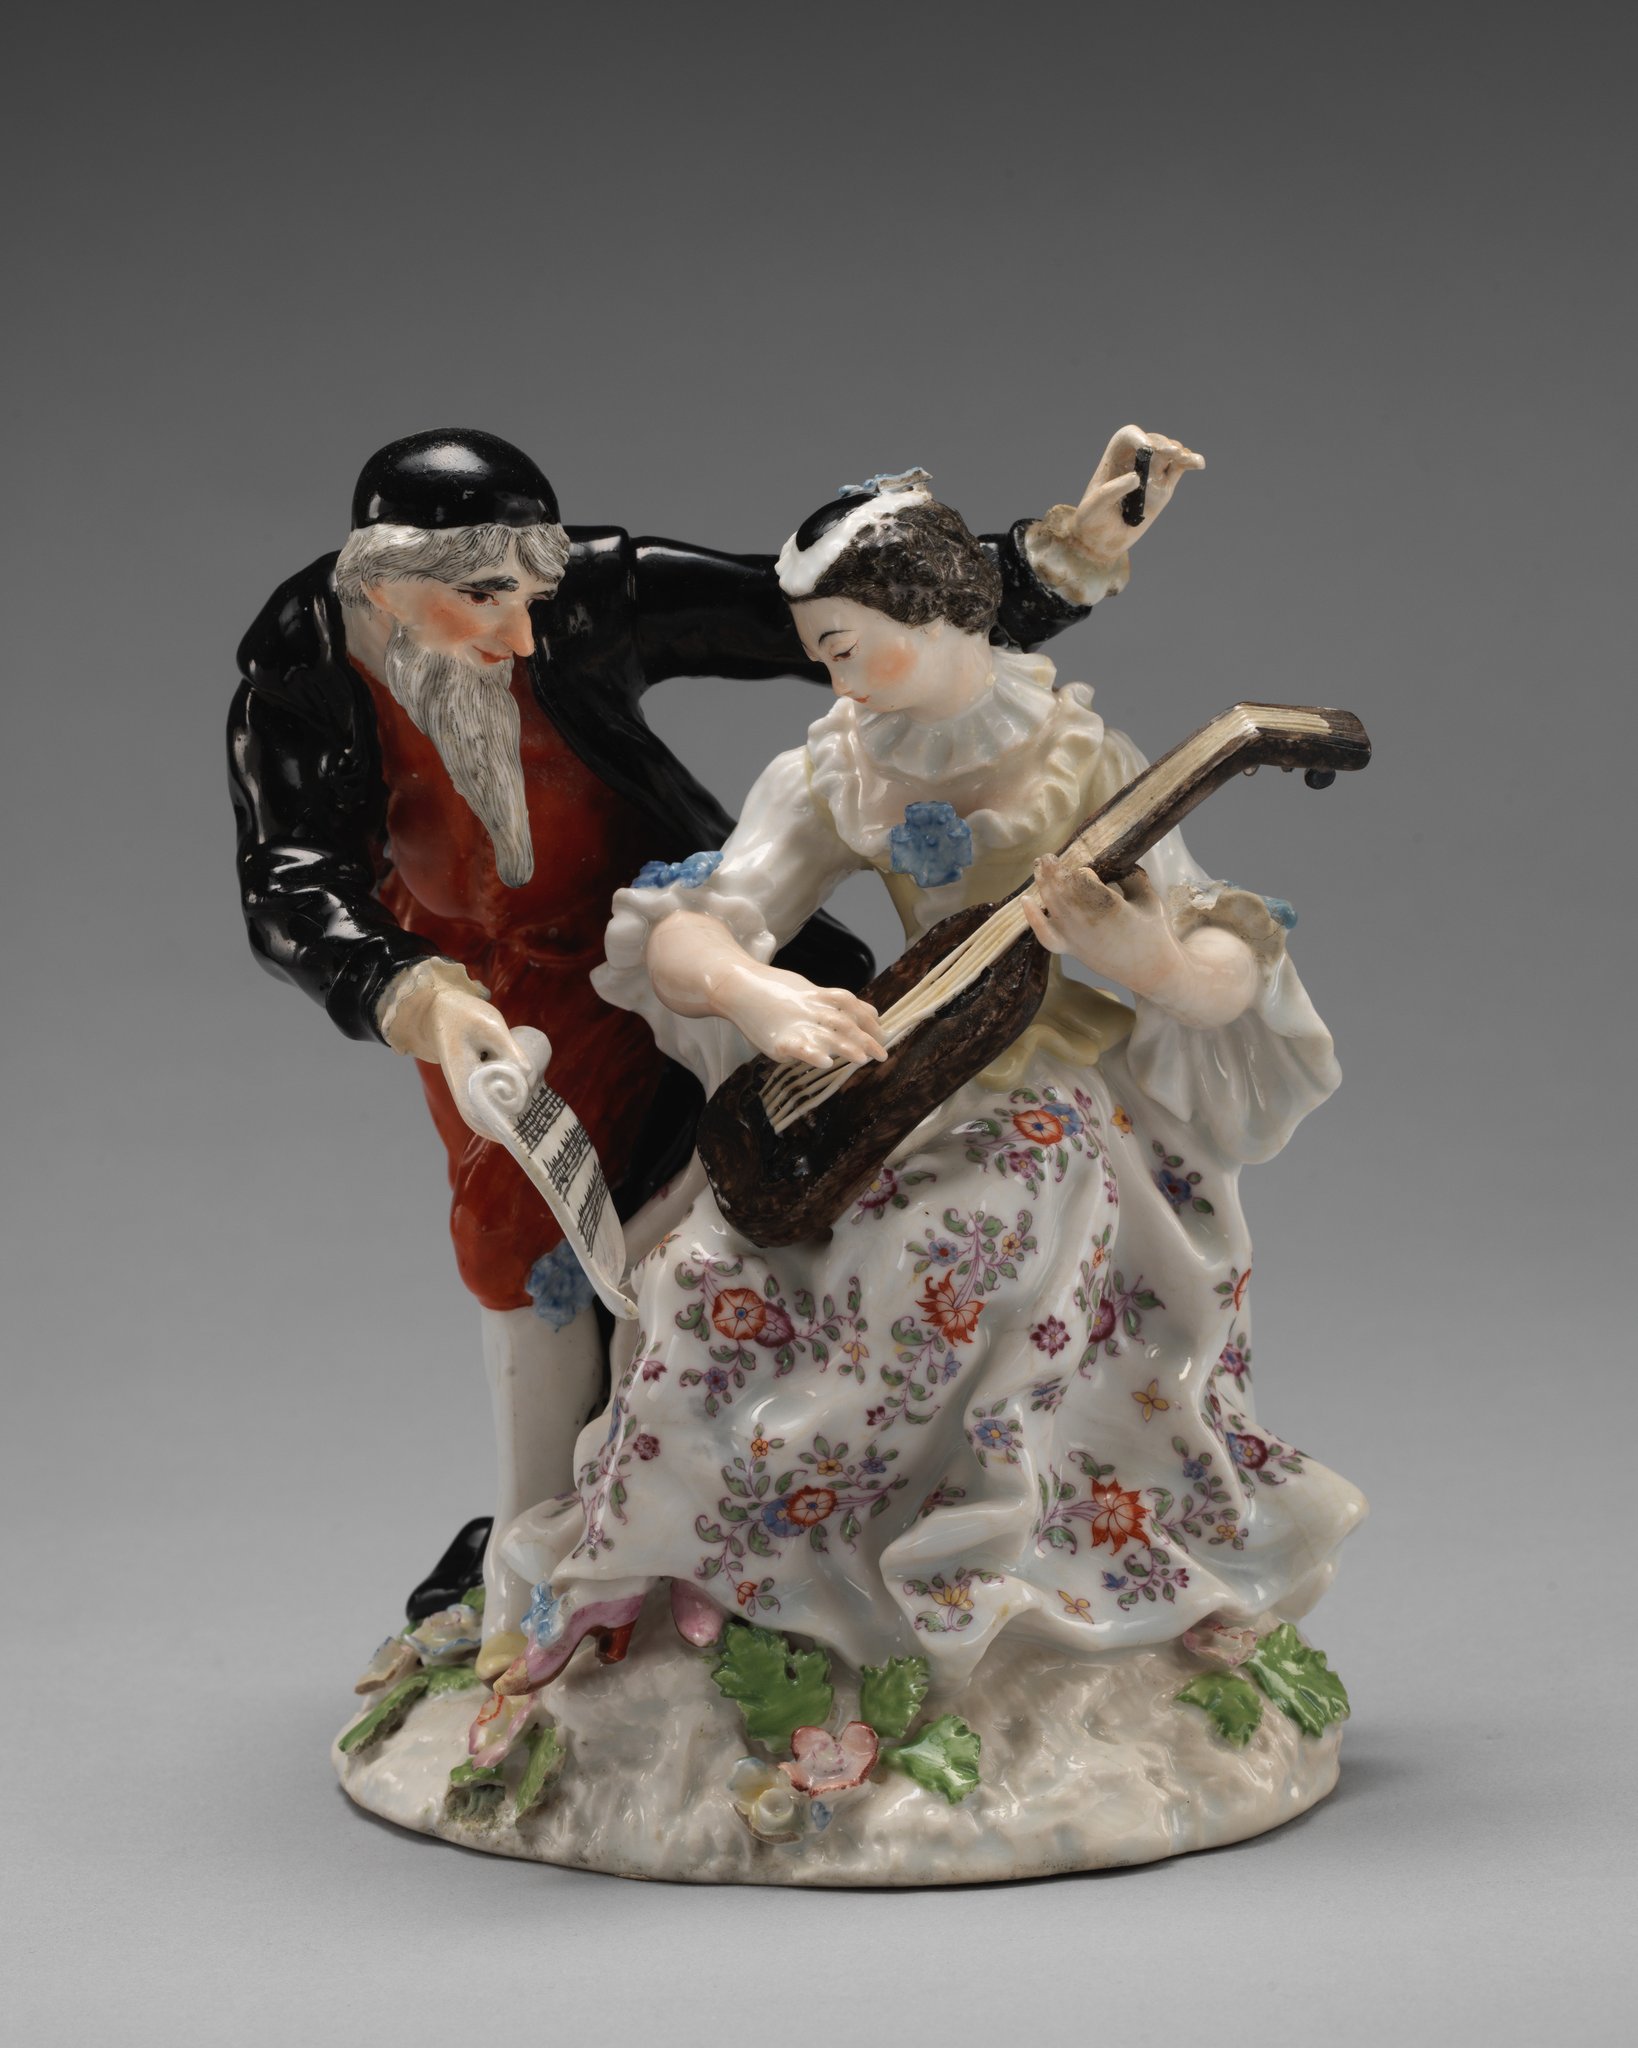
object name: group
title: Pantaloon and Columbine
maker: chelsea porcelain manufactory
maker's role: factory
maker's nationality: british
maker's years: 1744-1784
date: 1753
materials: soft paste porcelain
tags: musical instruments,men,women,musicians